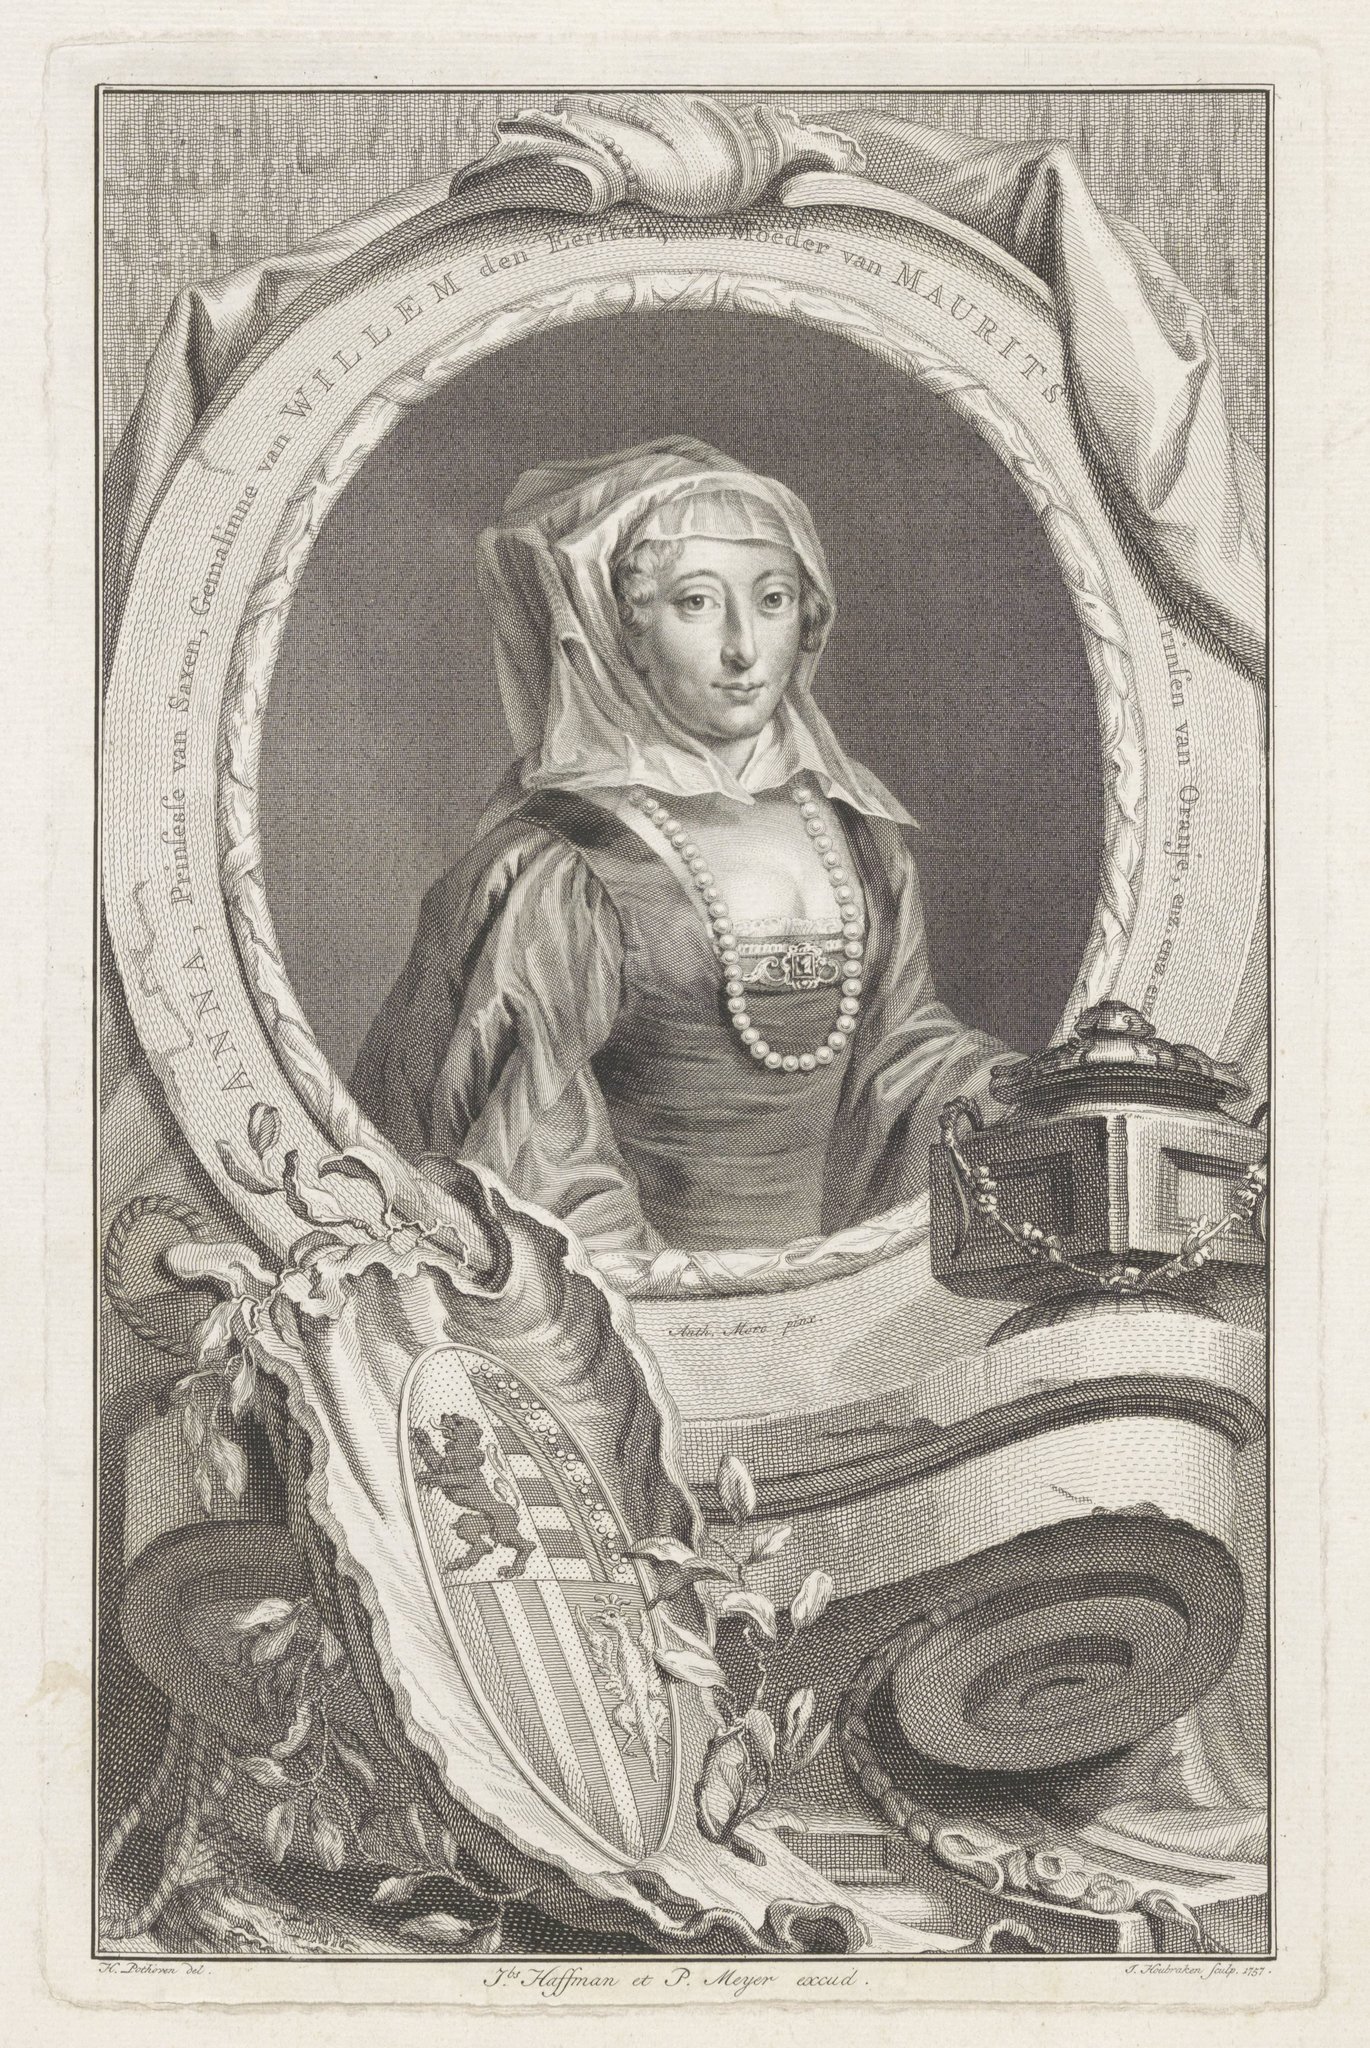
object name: print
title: Portret van Anna van Saksen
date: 1757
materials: paper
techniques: engraving, etching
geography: amsterdam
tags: dresden, anna van saksen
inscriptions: date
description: Portret van Anna in een ovaal met randschrift. Rondom ligt een aantal allegorische objecten.